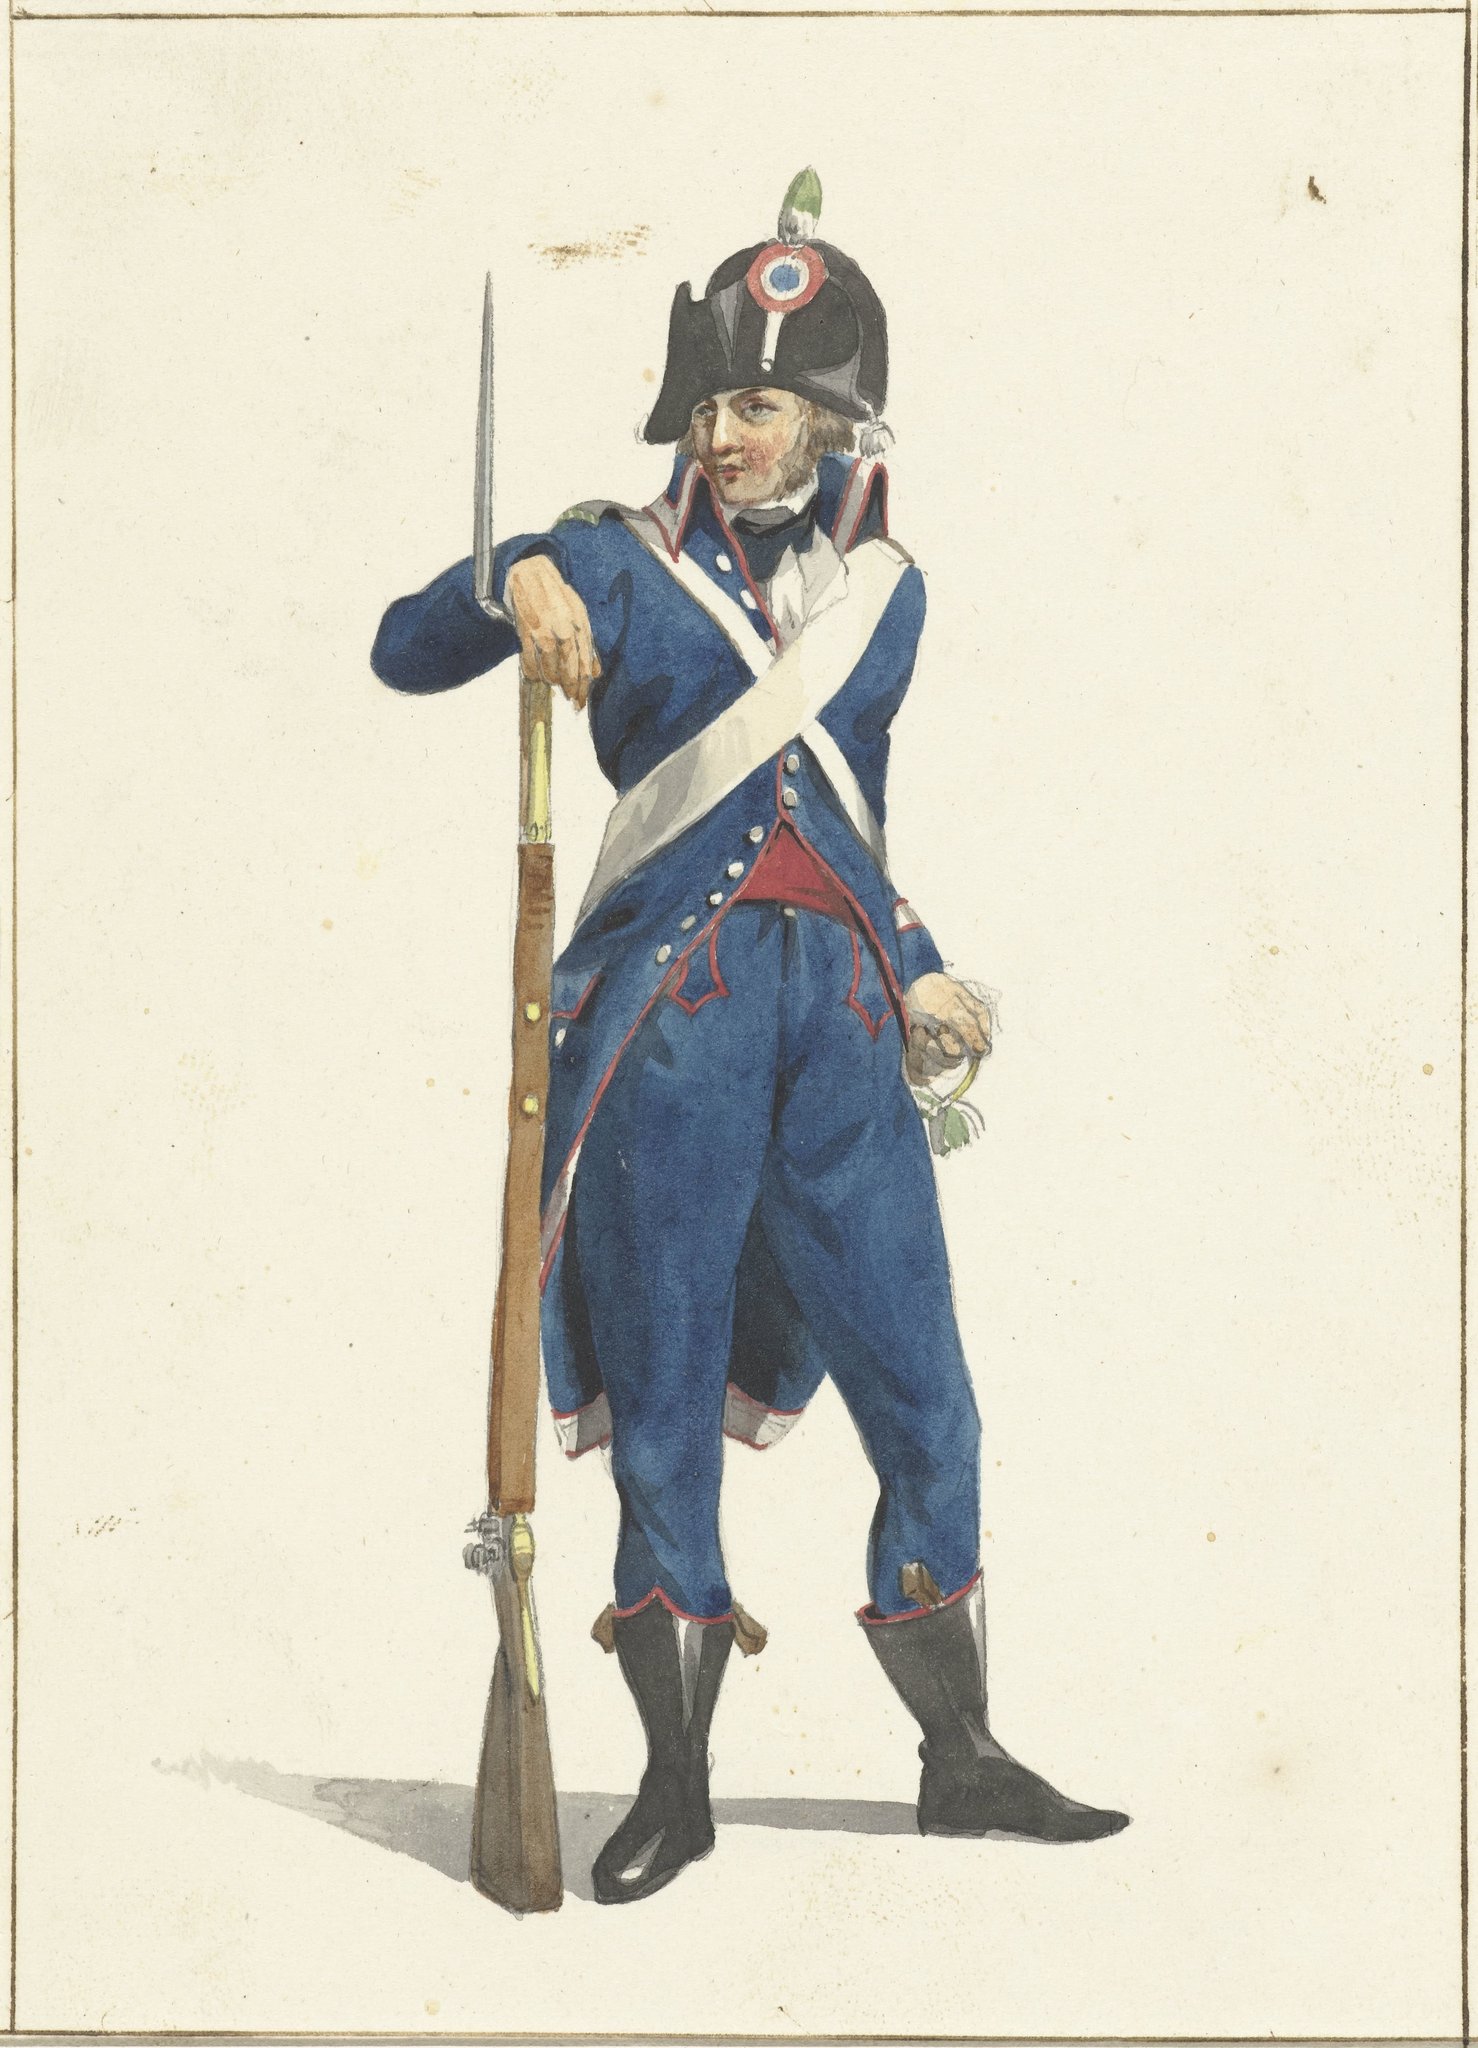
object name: watercolor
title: Member of the Rotterdam armed citizen force with a rifle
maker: dirk langendijk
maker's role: draughtsman, painter, print maker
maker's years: 1748-1805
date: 1758-1805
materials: ink, paper, watercolor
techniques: brush, pen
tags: handling of weapons ~ military training